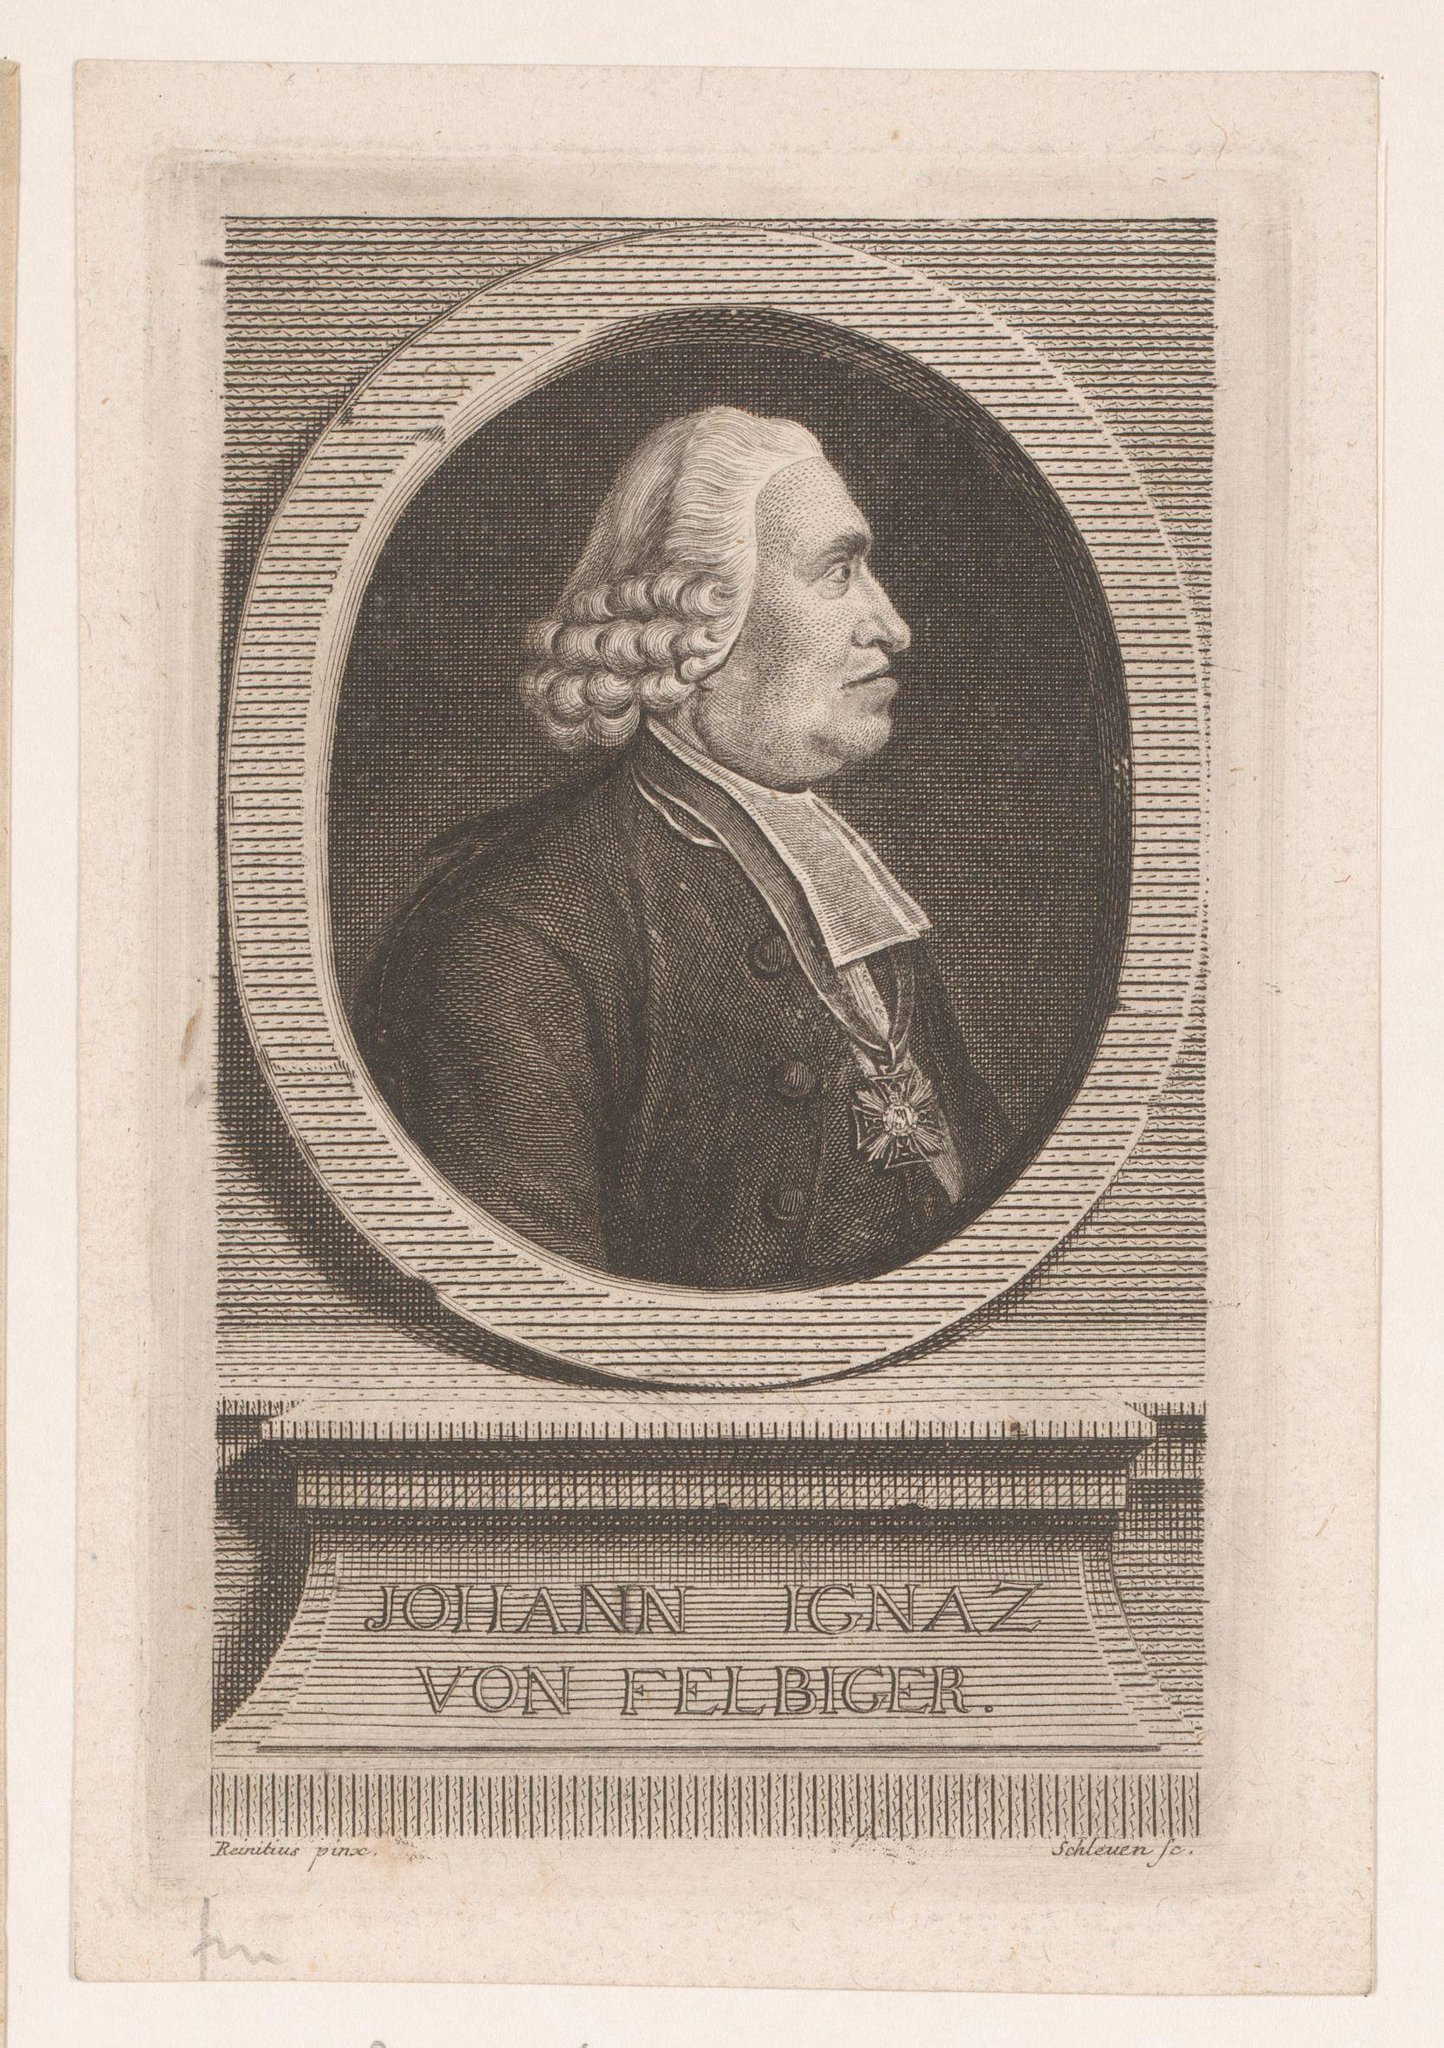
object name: print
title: Portret van Johann Ignaz Felbiger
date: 1721-1771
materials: paper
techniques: engraving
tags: historical persons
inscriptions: collector's mark: Lugt 2228